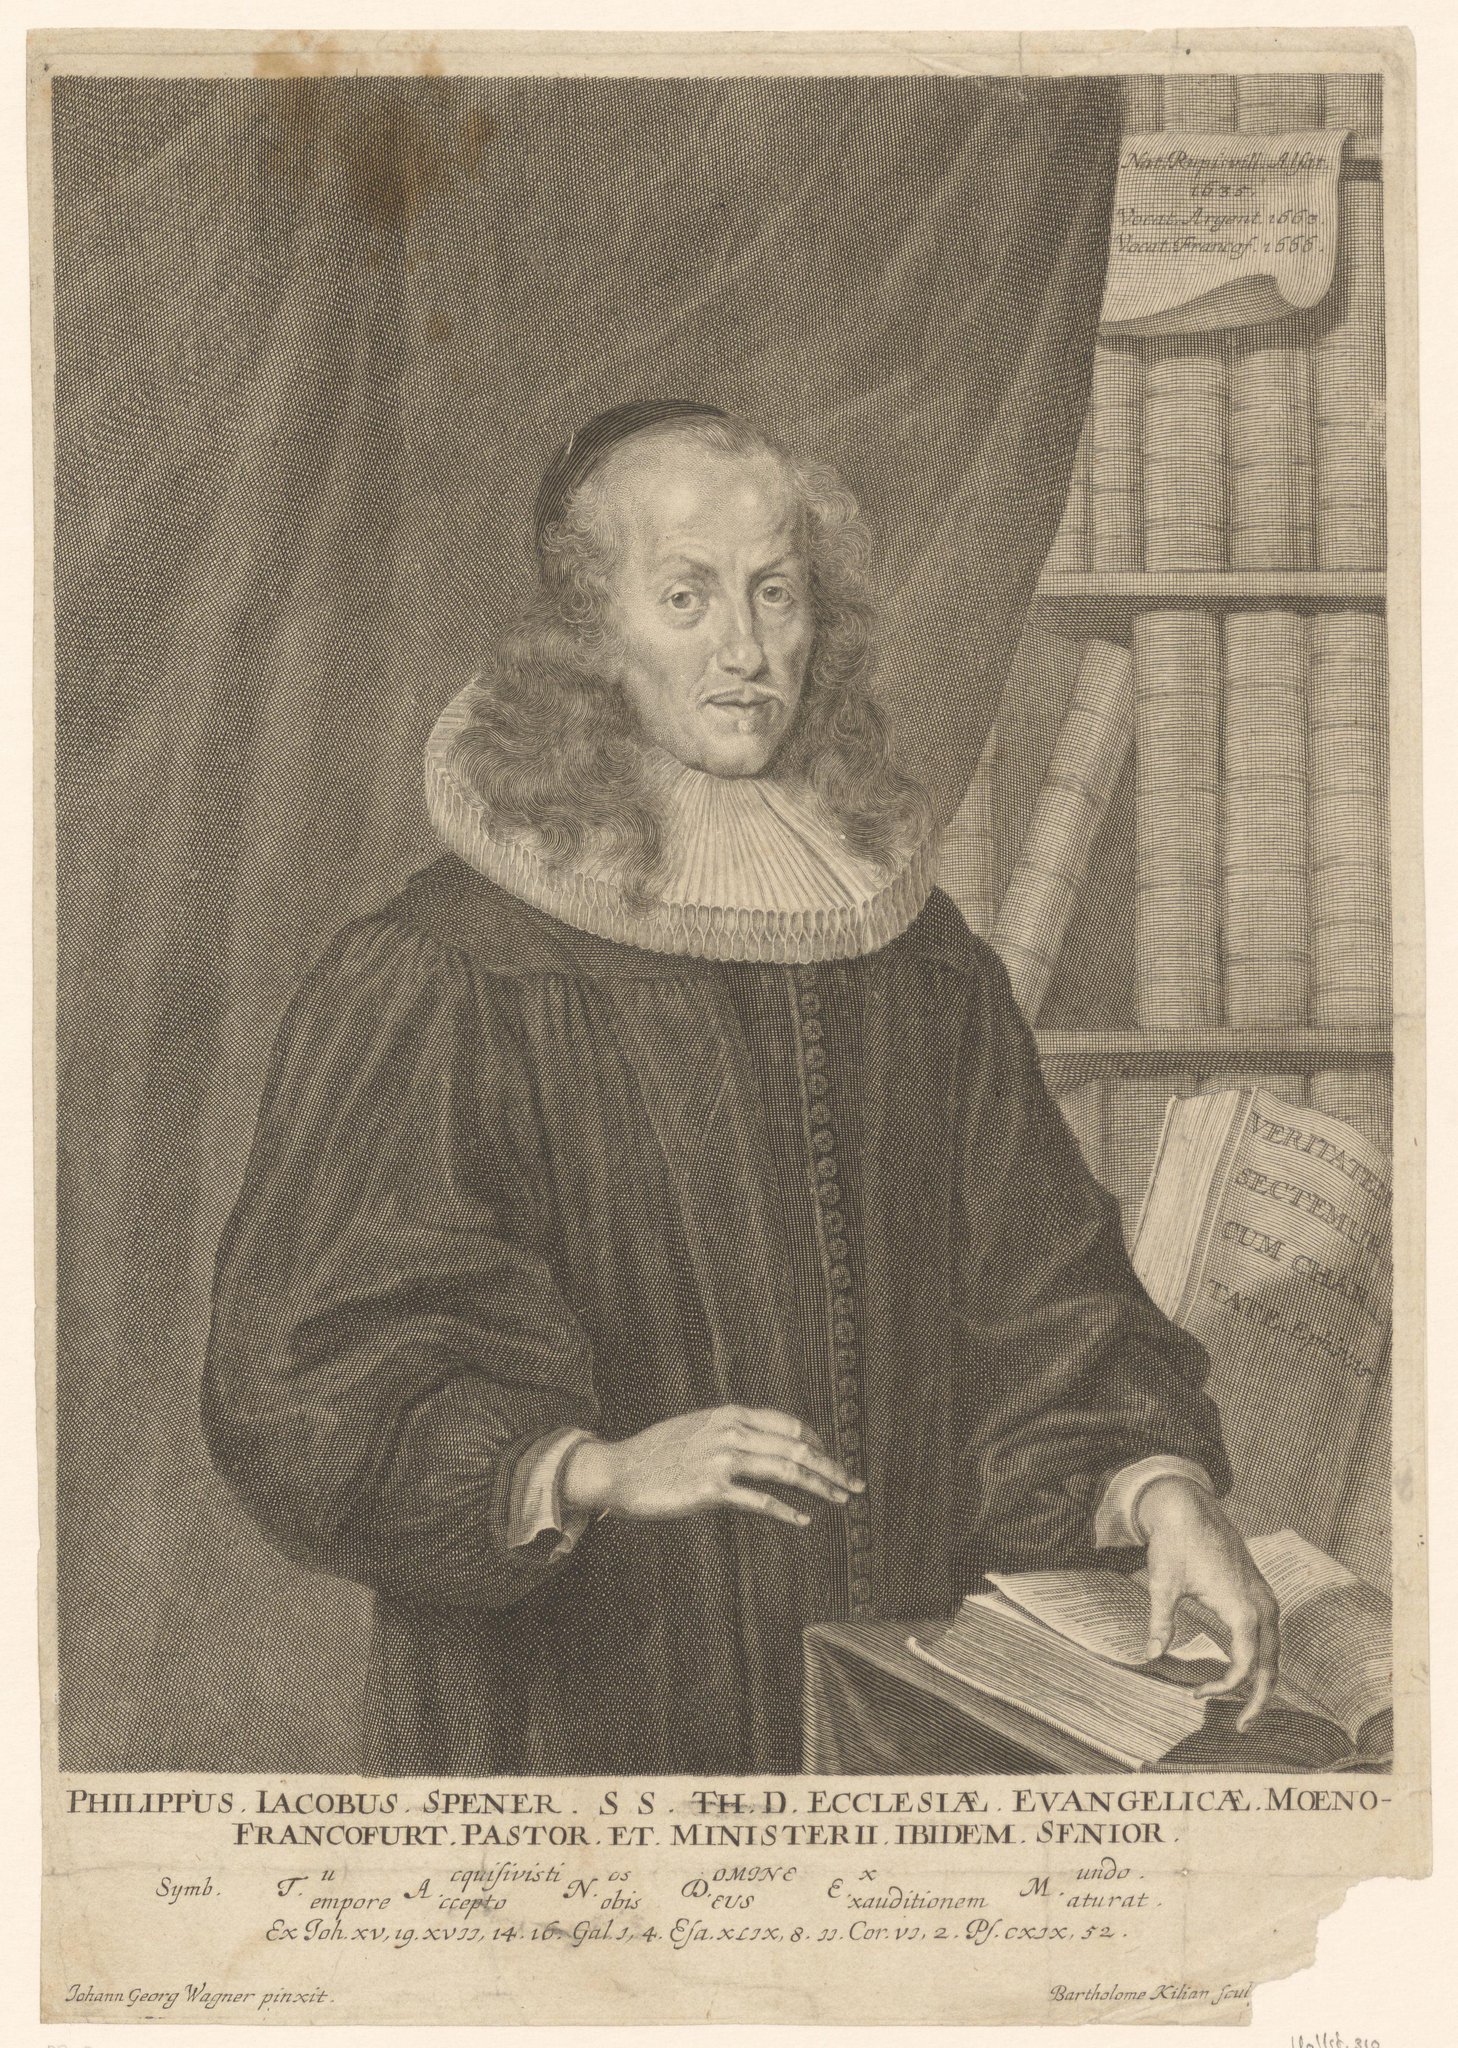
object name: print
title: Portret van Philipp Jacob Spener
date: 1666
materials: paper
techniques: engraving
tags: berlin, philipp jacob spener, theologian, historical persons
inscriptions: collector's mark: Lugt 2228